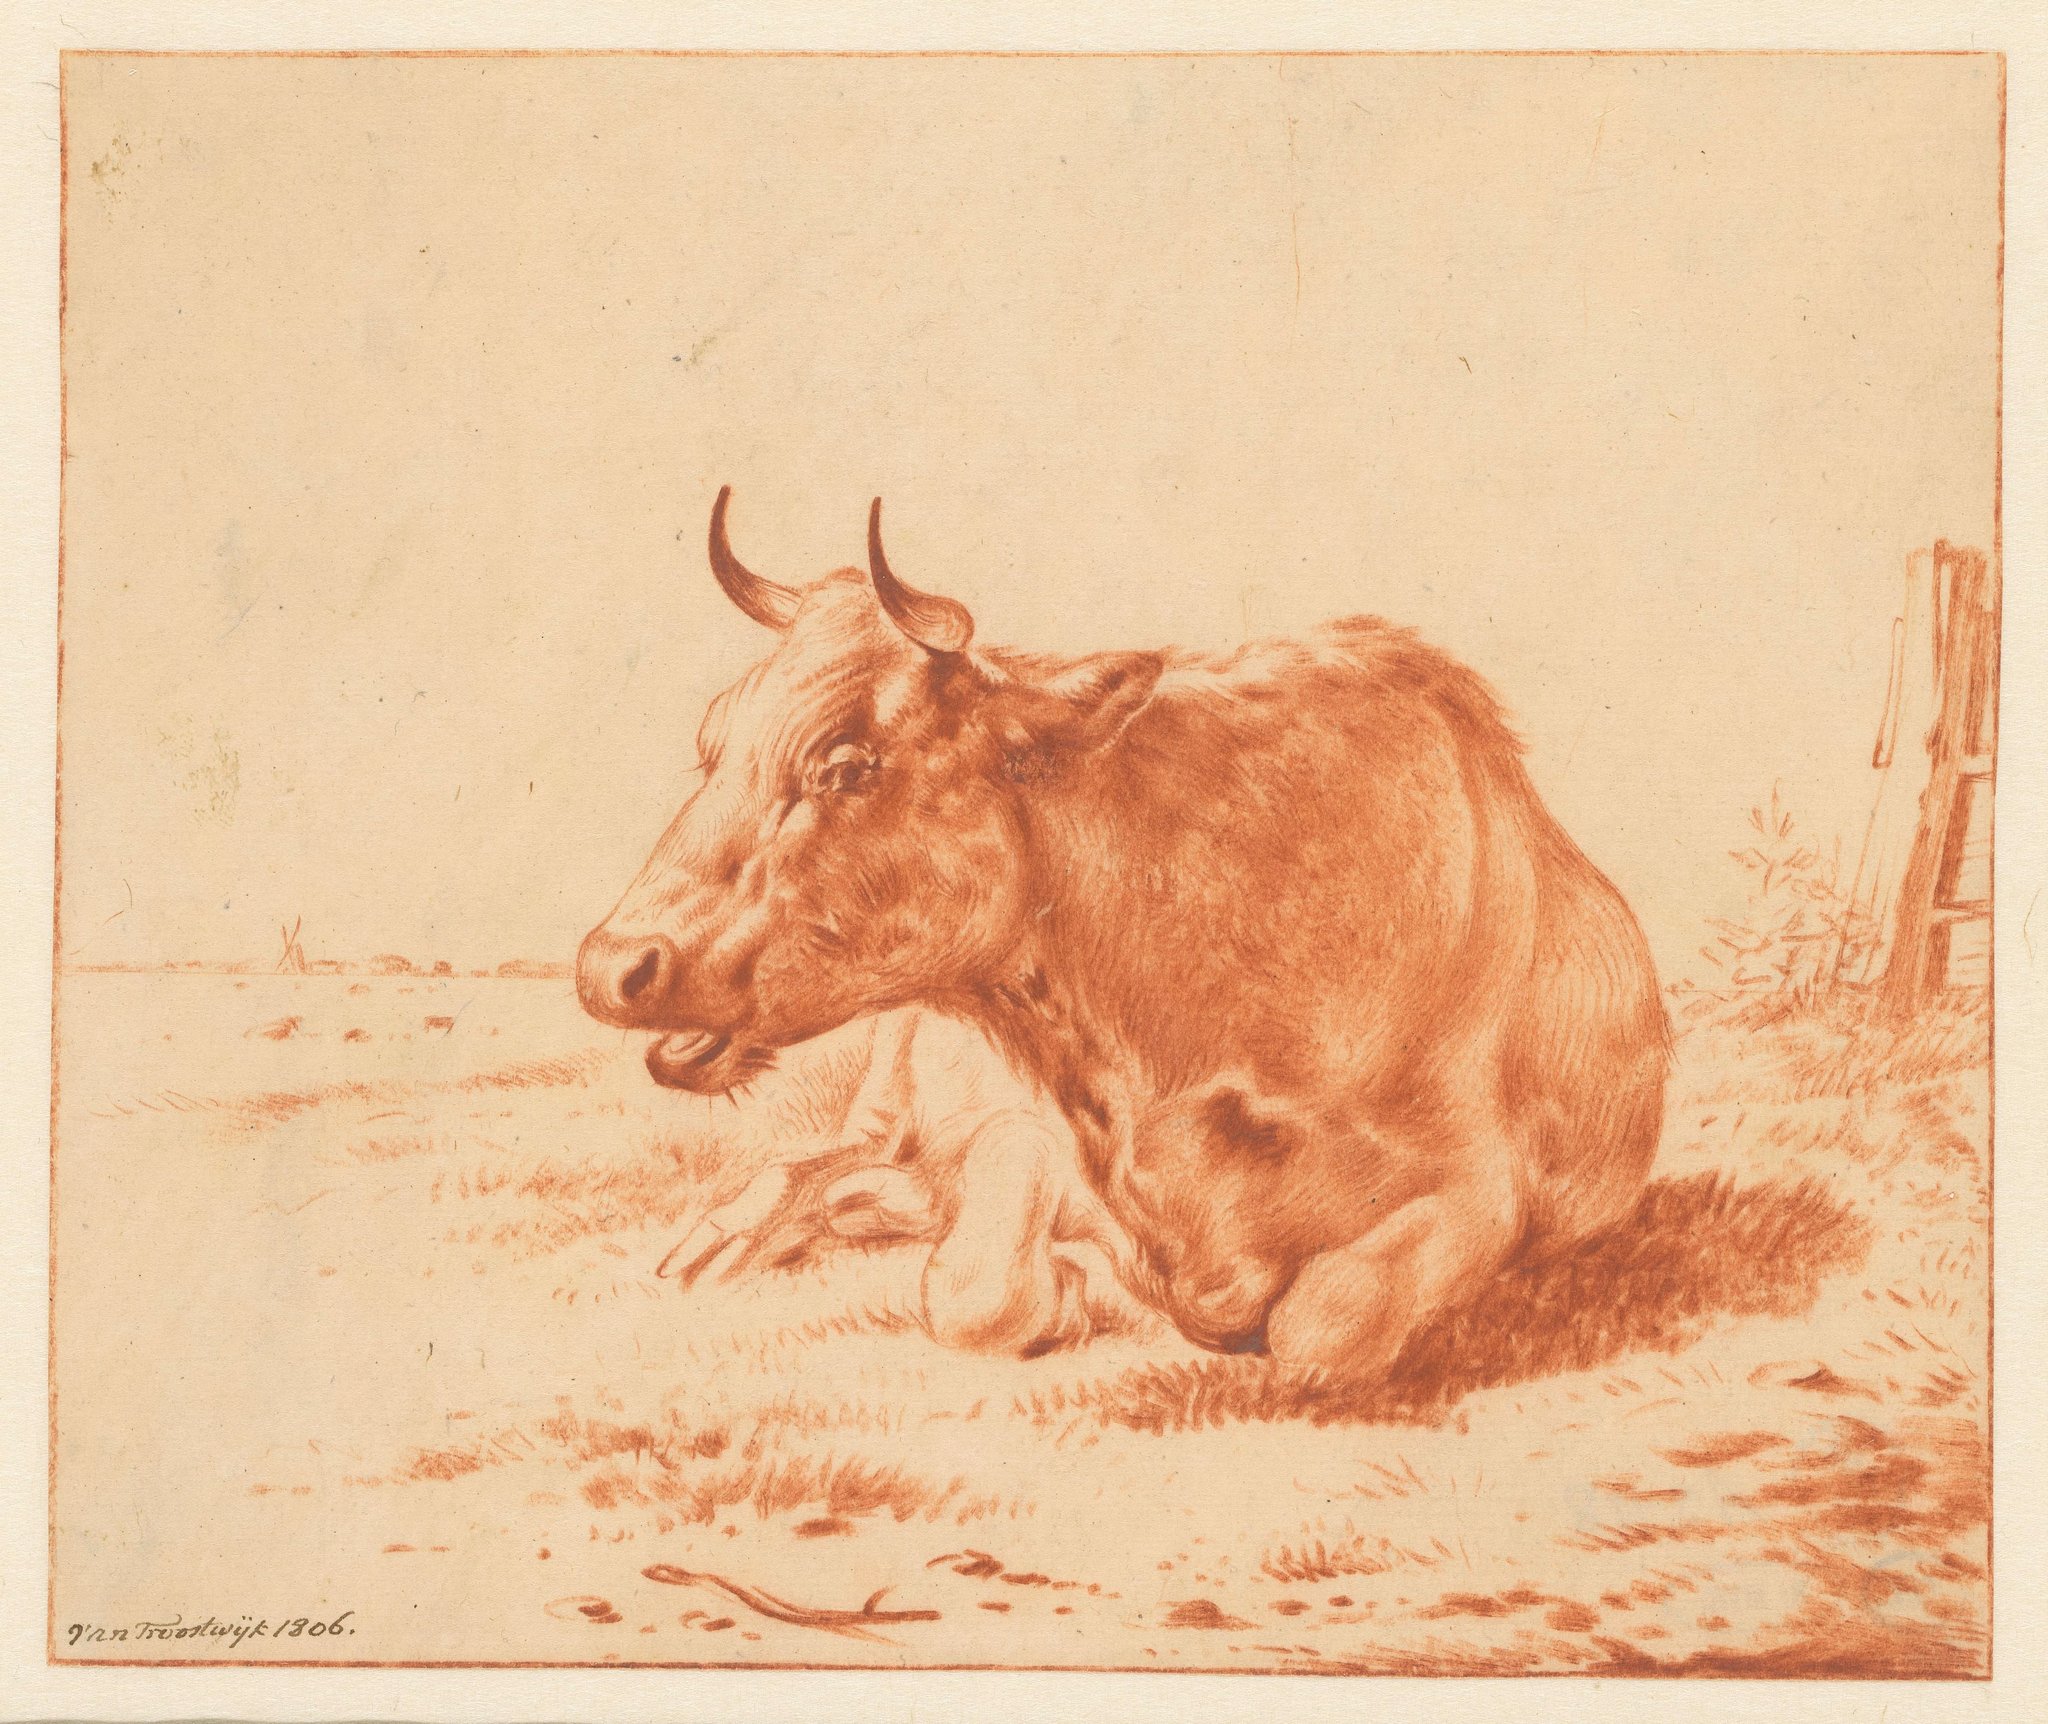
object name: drawing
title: Landschap met liggende koe van voren gezien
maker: wouter johannes van troostwijk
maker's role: draughtsman, painter, print maker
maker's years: 1782-1810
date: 1806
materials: chalk, paper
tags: cow